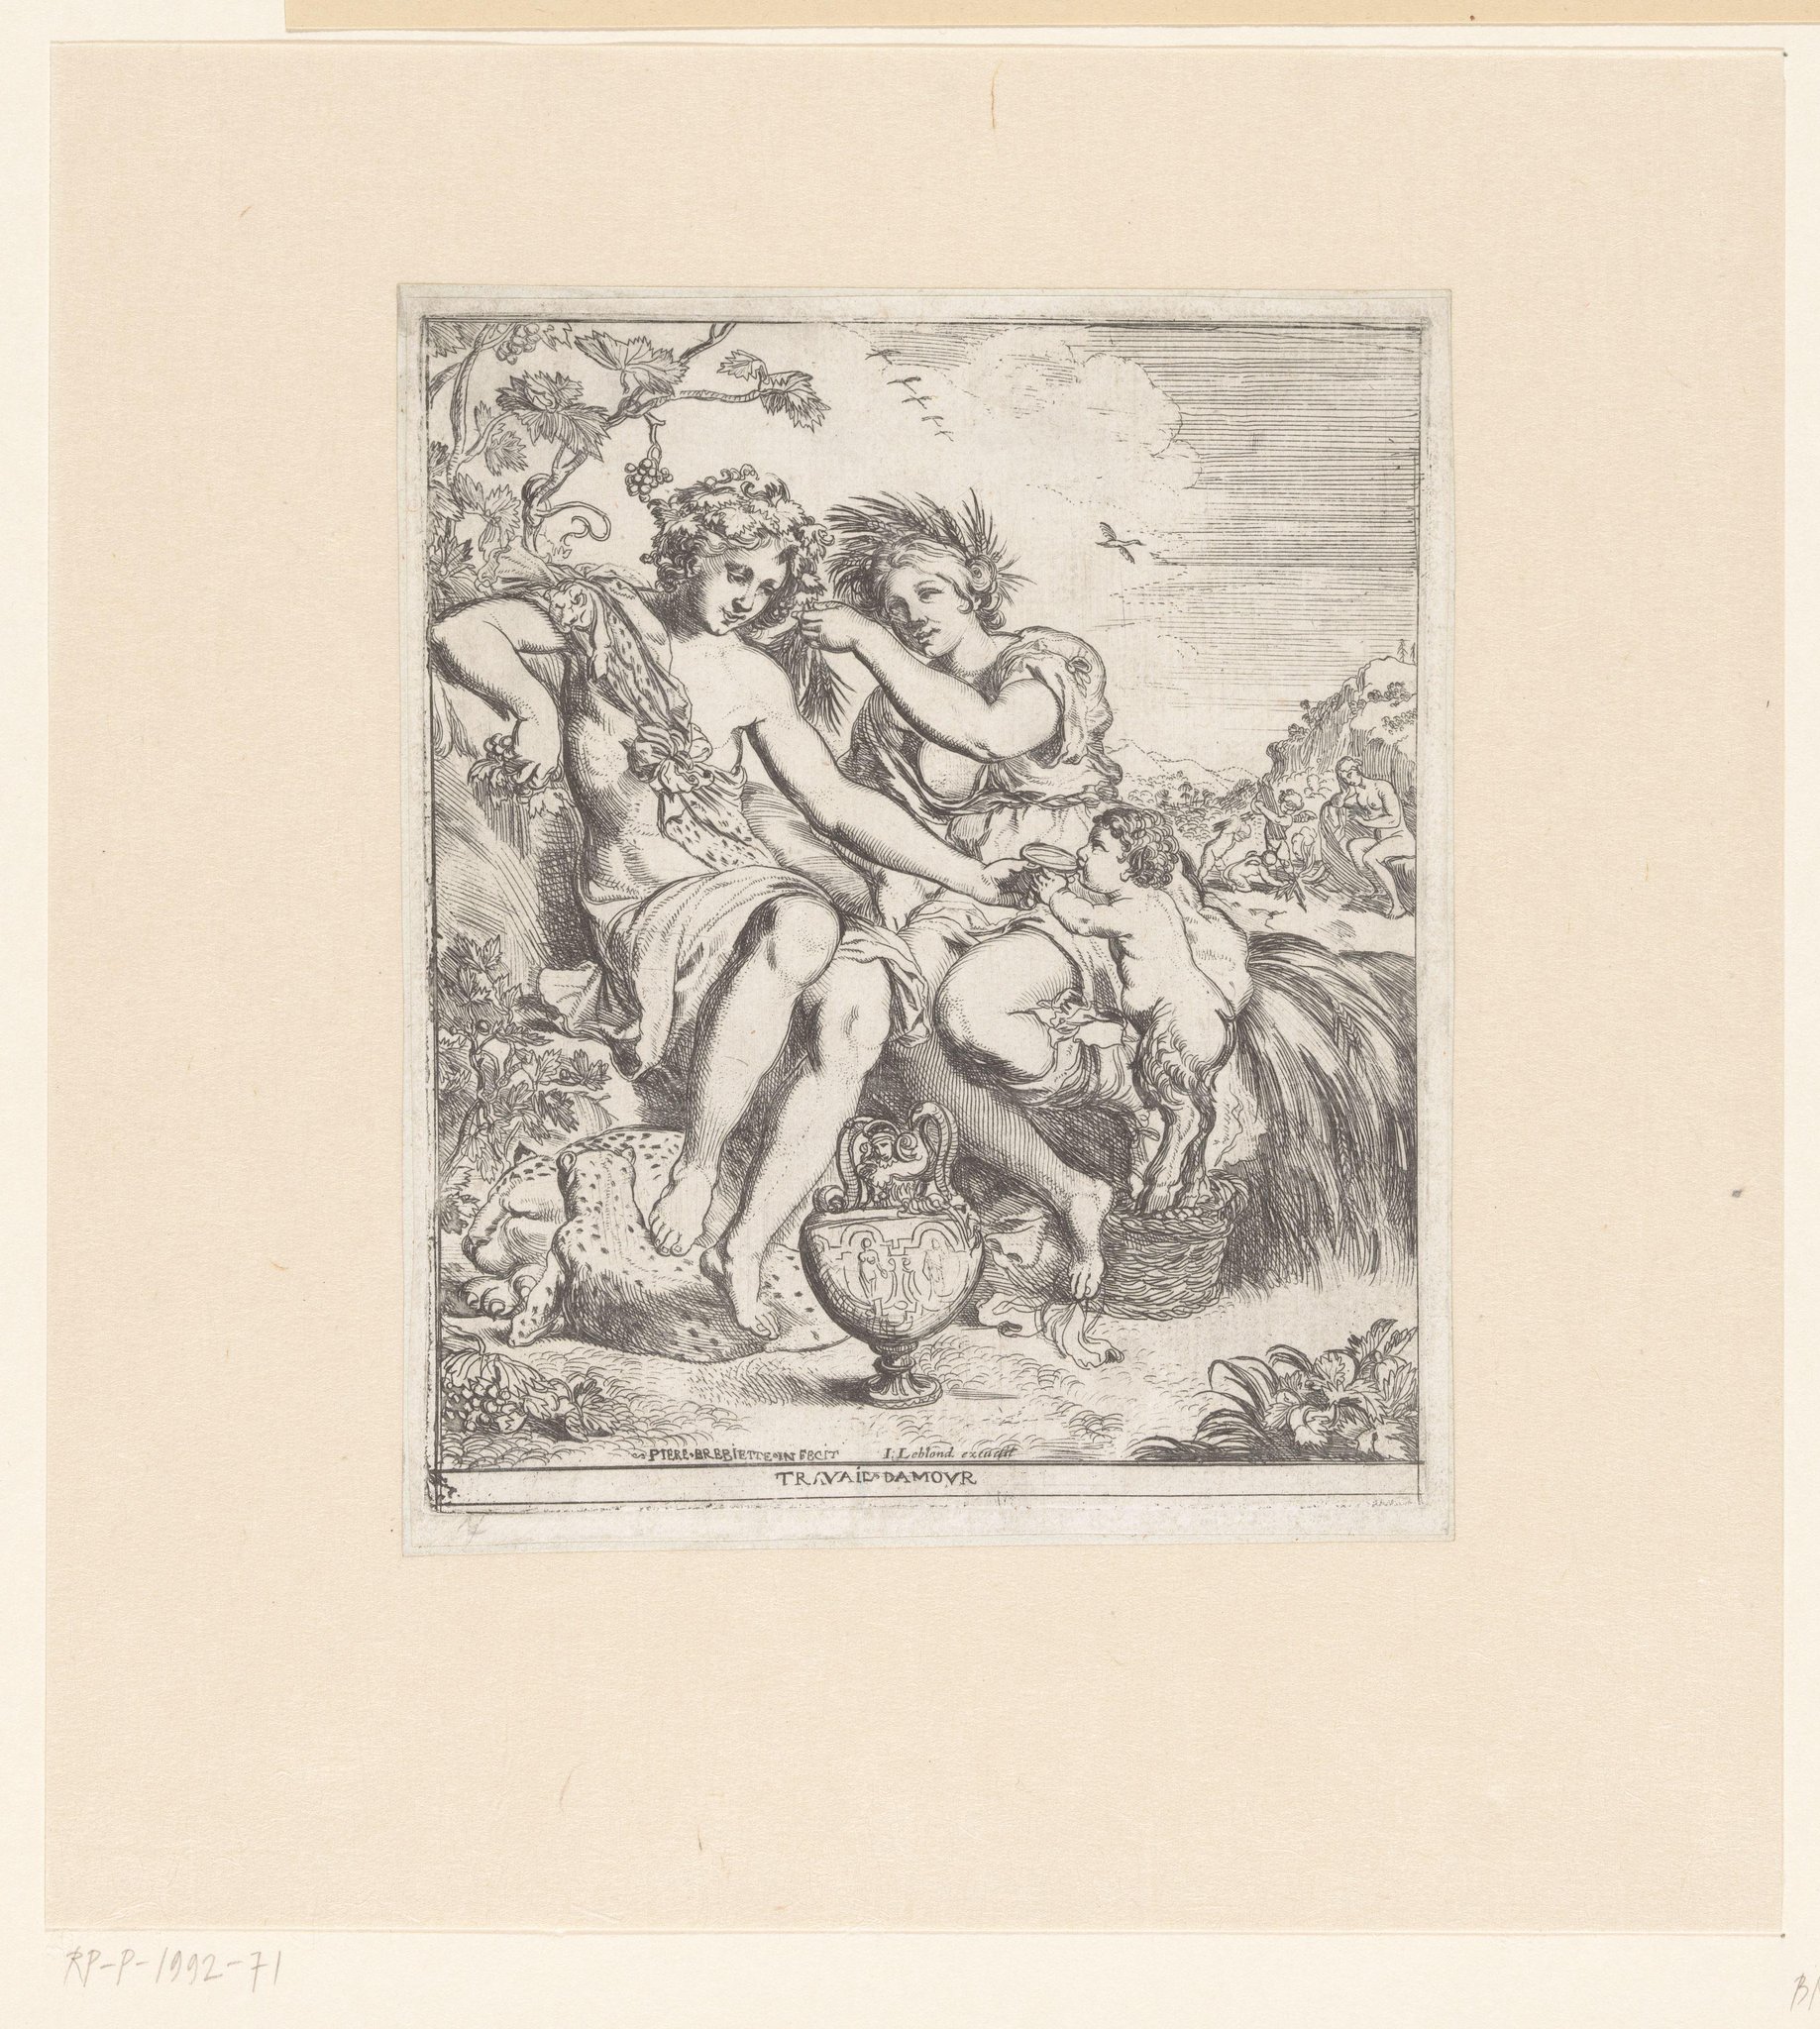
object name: print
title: Bacchus en Ceres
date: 1608-1650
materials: paper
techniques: engraving, etching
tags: beasts of prey, predatory animals: leopard, non-aggressive, friendly or neutral activities and relationships of ceres, urn, non-aggressive, friendly or neutral activities and relationships of bacchus, grape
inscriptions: collector's mark: Lugt 2228, collector's mark: Lugt 2760